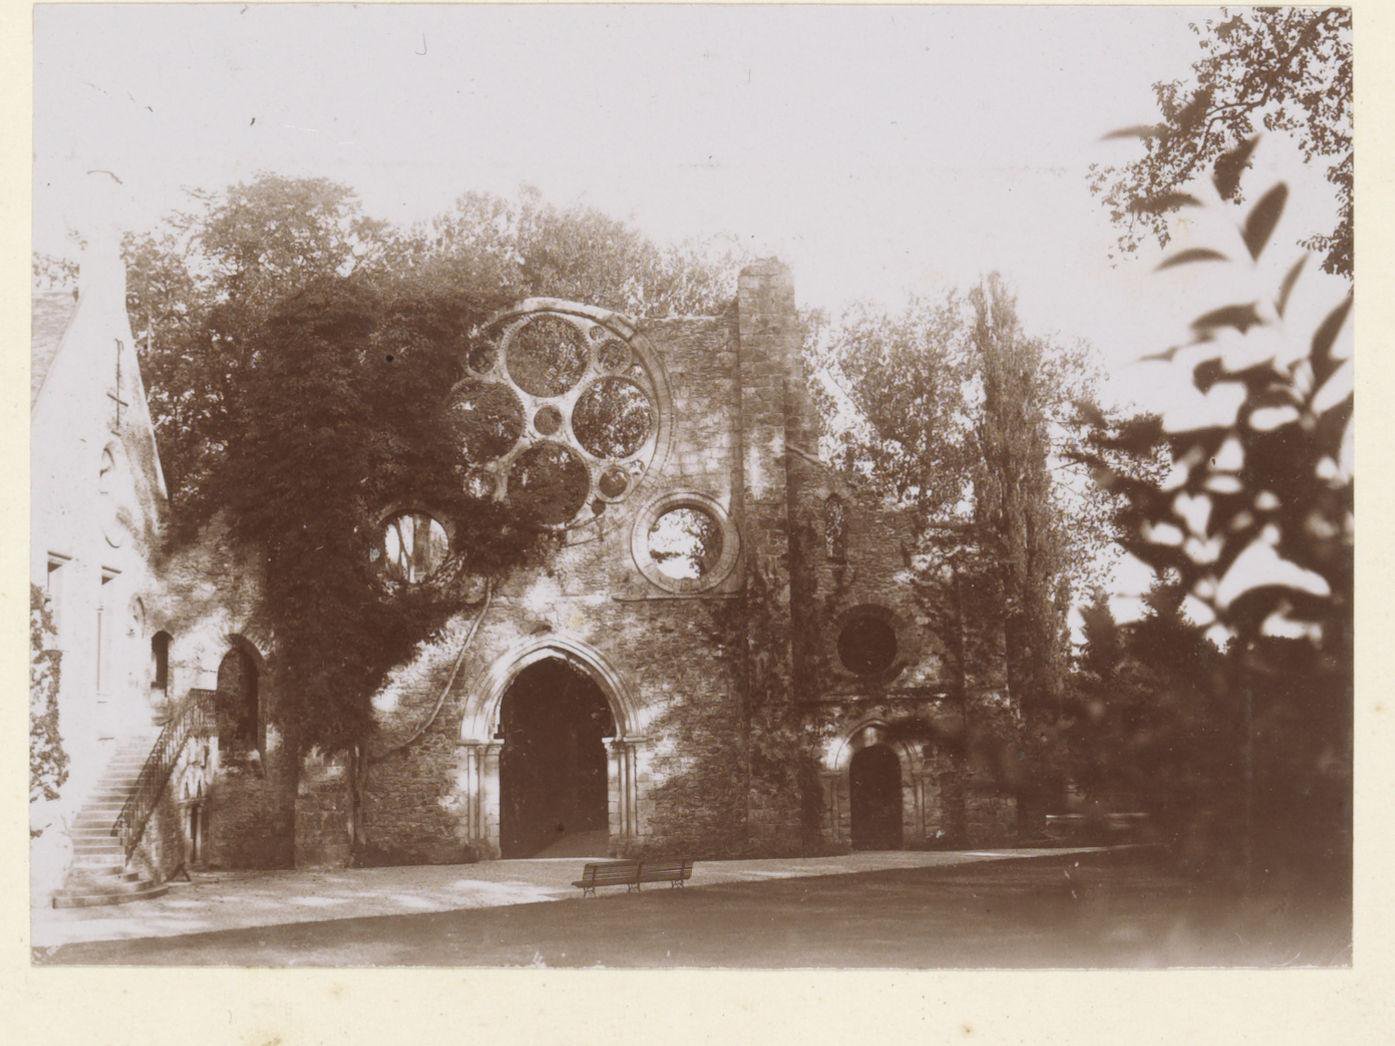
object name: photograph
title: Ruïne van een kerk in Frankrijk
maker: Anonymous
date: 1900-1910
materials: paper, photographic support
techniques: daylight paper print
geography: france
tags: ruin of a dwelling, house, castle, etc., france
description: Onderdeel van Fotoalbum van een Franse amateurfotograaf met opnames van een familie, distilleerderij Delizy & Doistau Fils, het leger en bezienswaardigheden in Frankrijk.